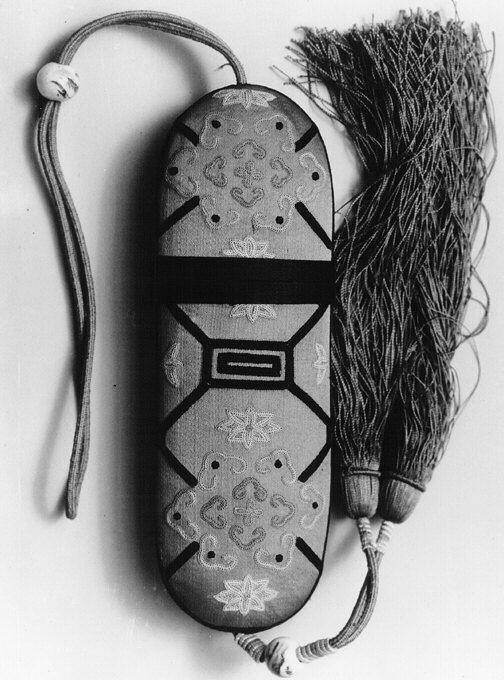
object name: eyeglass case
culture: chinese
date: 1701-1900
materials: silk